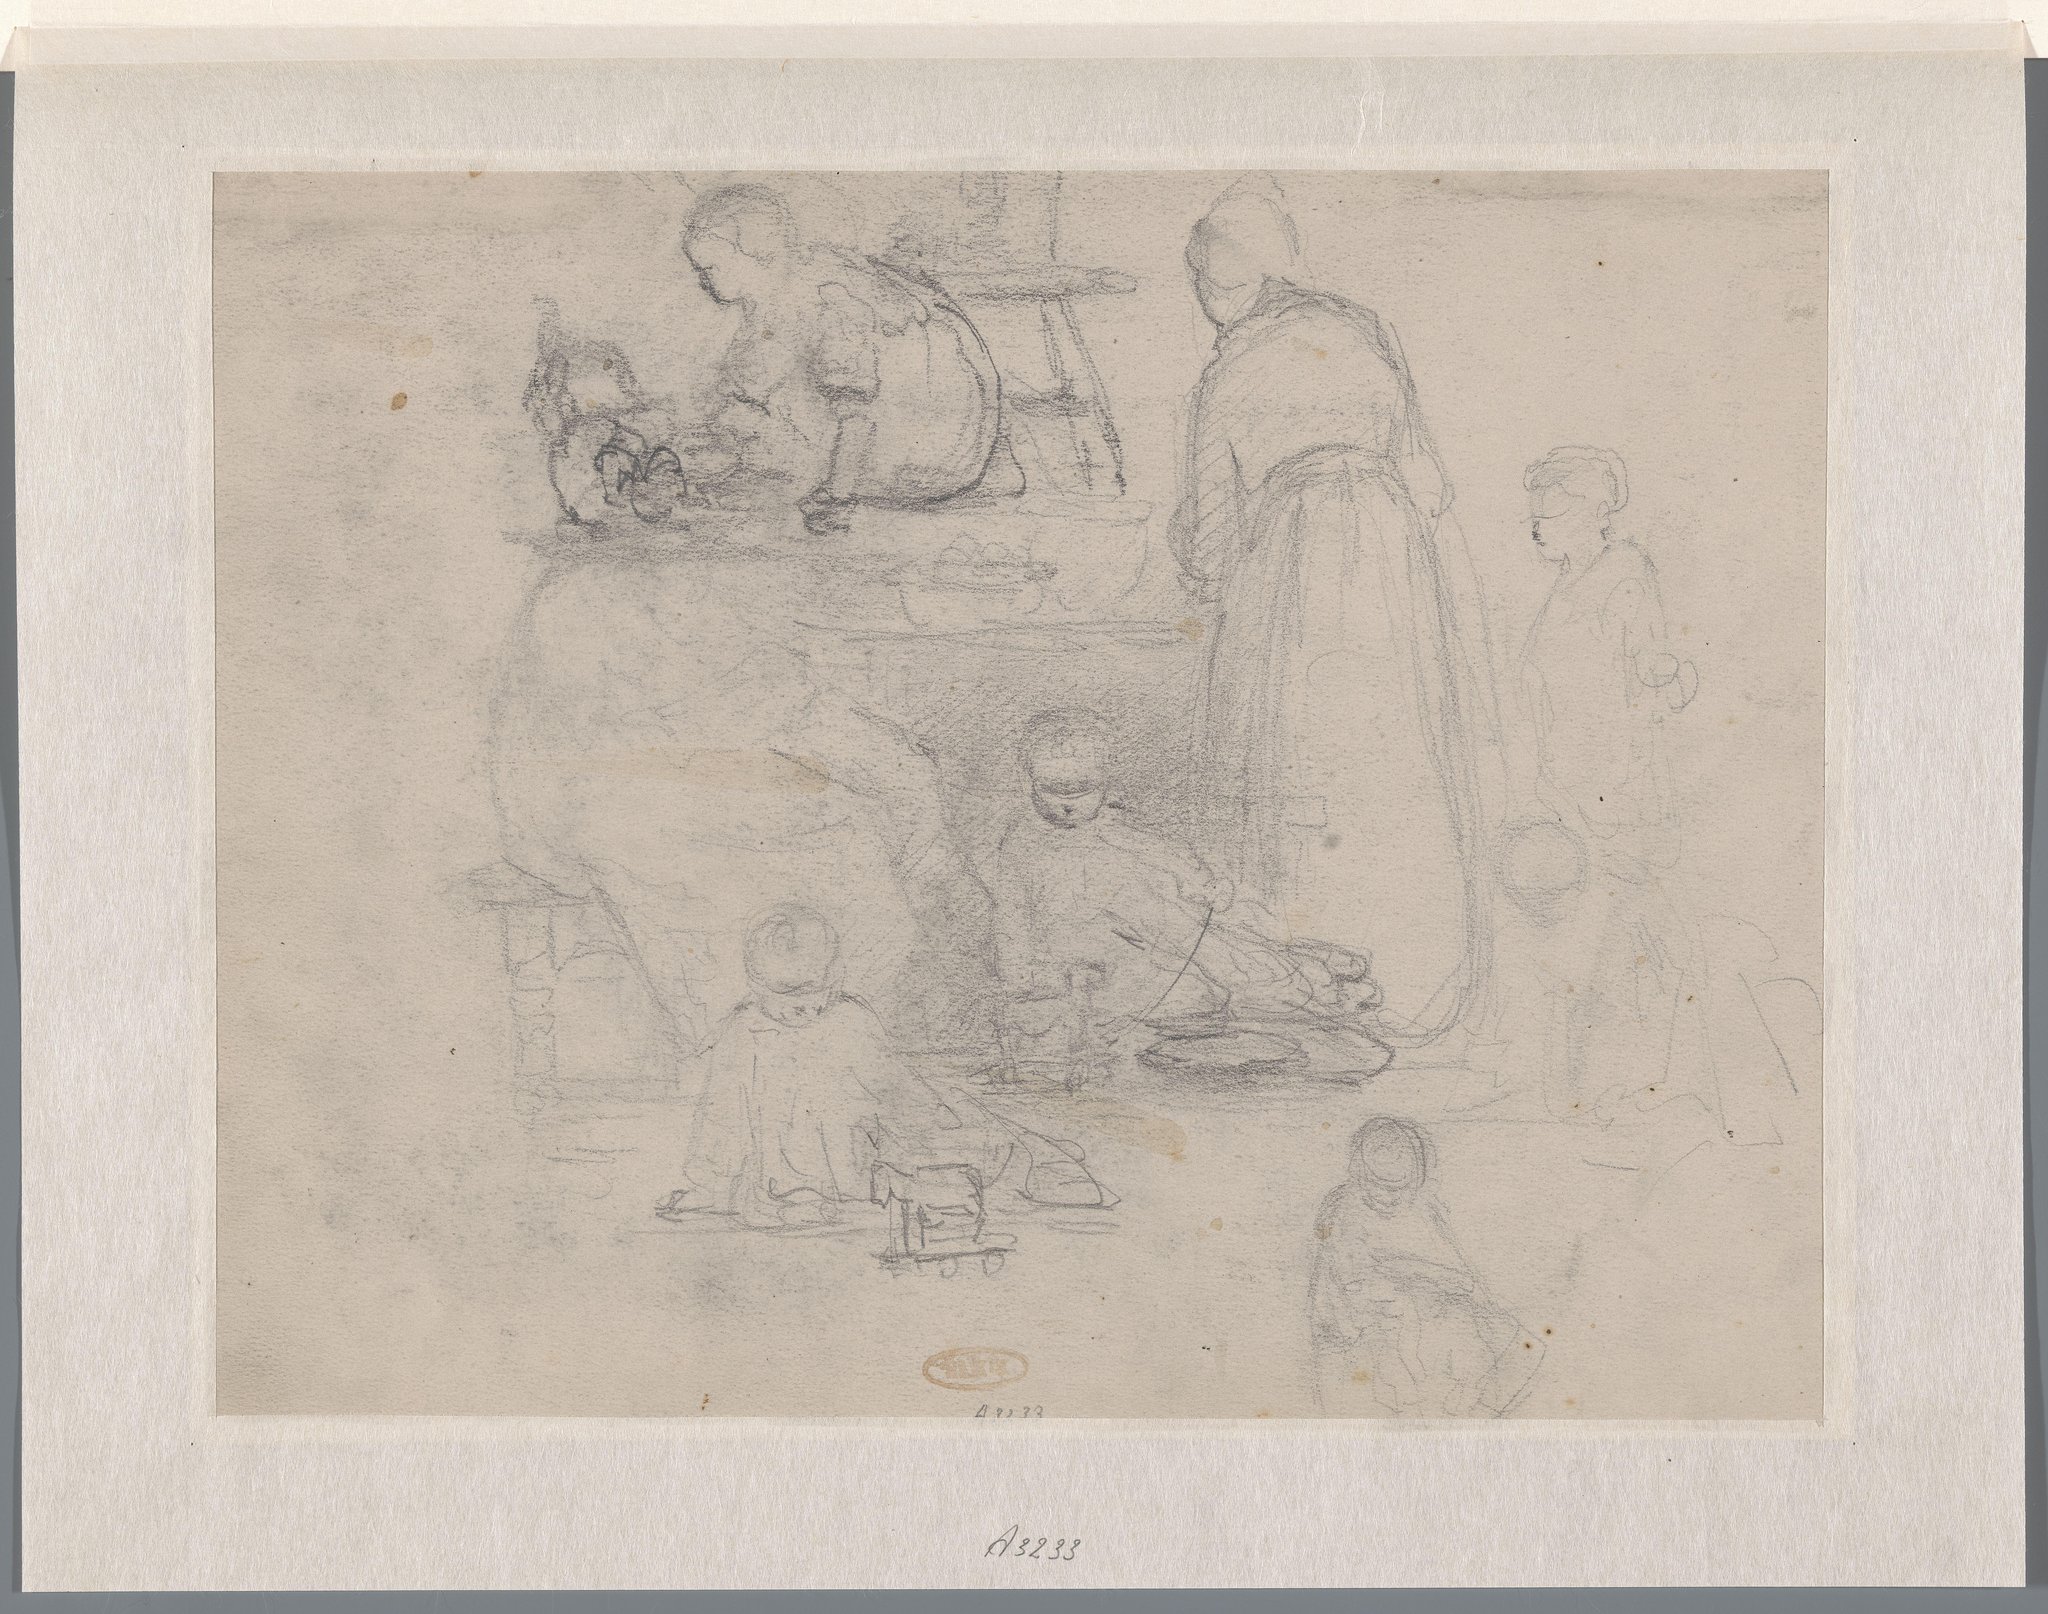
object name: drawing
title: Moeder met spelende kinderen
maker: hendrik valkenburg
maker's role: draughtsman, painter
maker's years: 1826-1896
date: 1836-1896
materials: chalk, paper, pencil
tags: adult woman, interior of the house, mother and child(ren), woman and child(ren) (family group)